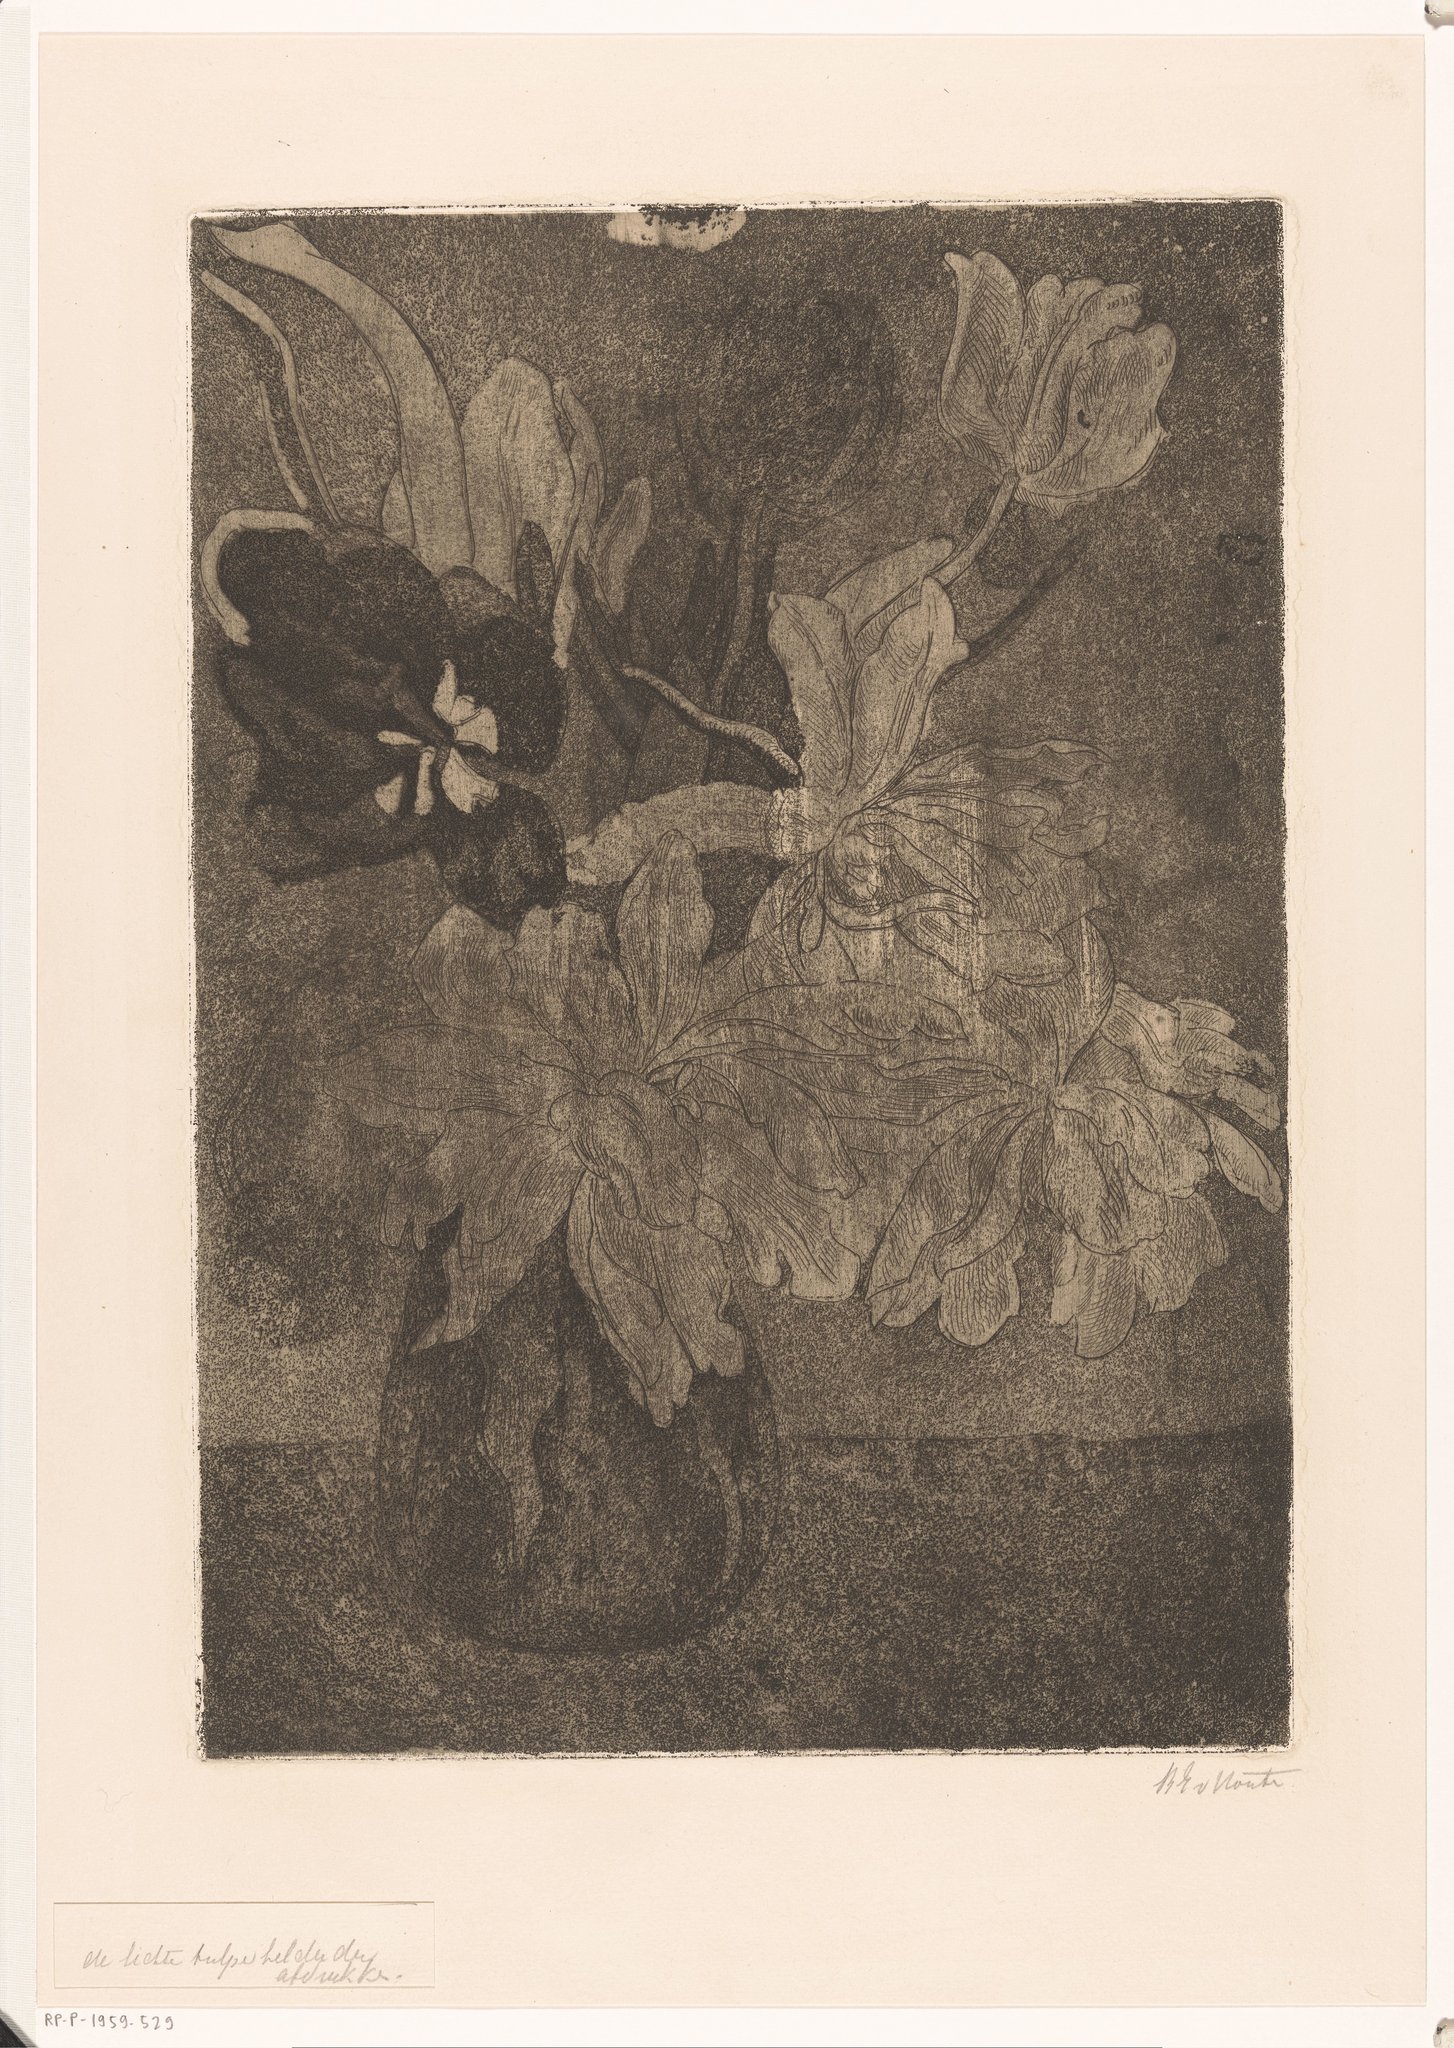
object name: print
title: Vaas met tulpen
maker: barbara elisabeth van houten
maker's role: draughtsman, print maker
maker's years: 1862-1950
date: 1872-1950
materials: paper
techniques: etching, intaglio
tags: flowers: tulip, flowers in a vase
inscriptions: collector's mark: Lugt 2228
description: Bij de prent wordt een aantekening bewaard met daarop de tekst: 'De lichte tulpen helderder afdrukken.'